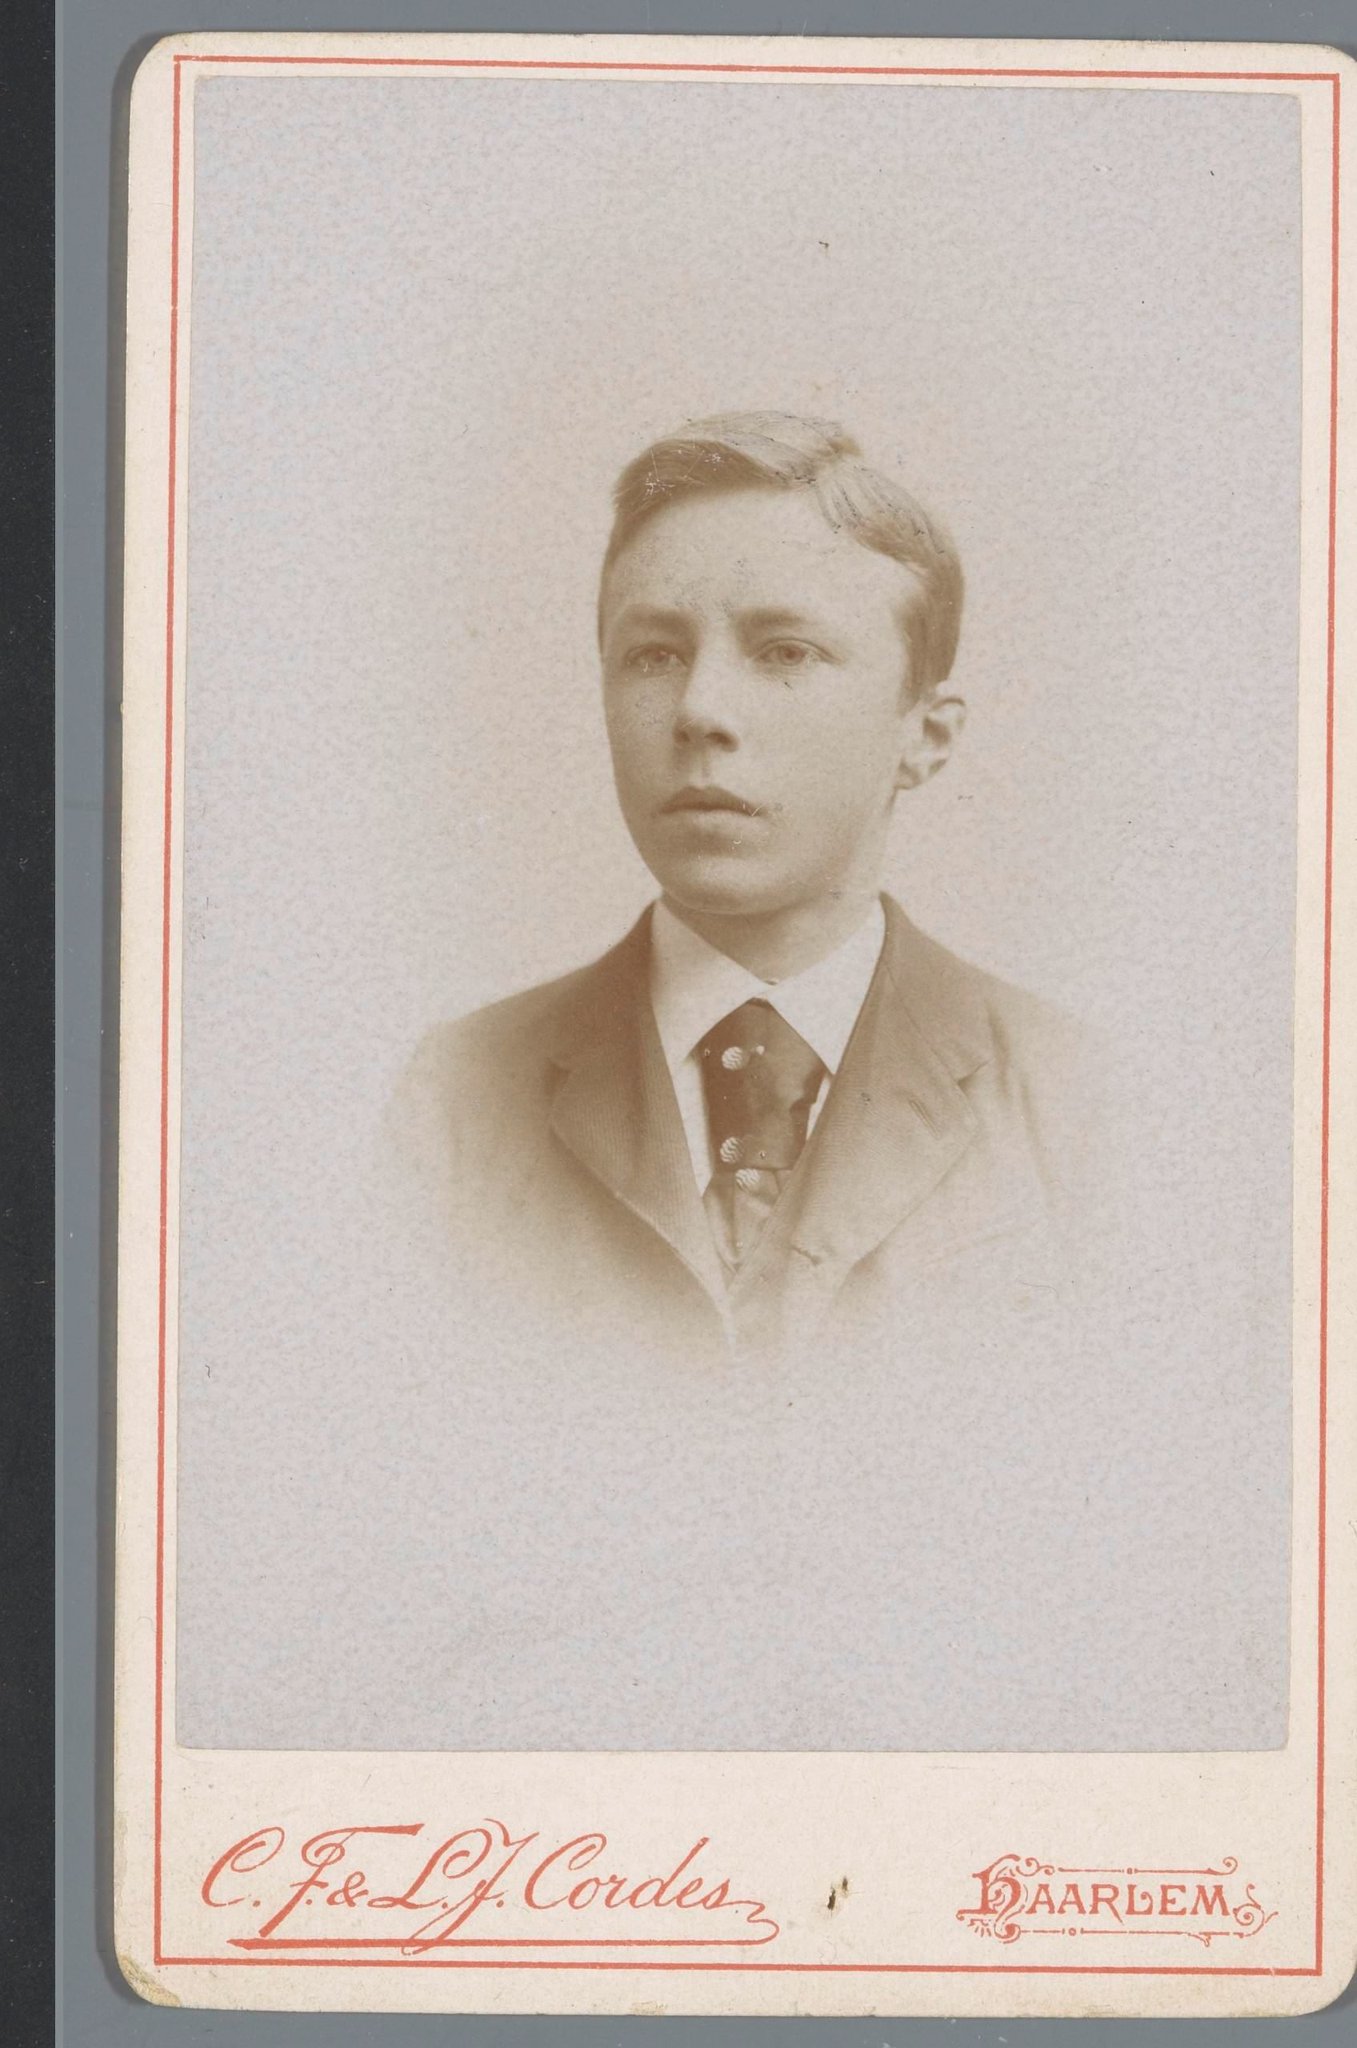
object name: carte de visite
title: Portret van een onbekende jongen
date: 1888-1901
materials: paper, cardboard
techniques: collodion silver print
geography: haarlem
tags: boy (child between toddler and youth), anonymous historical person portrayed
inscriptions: inscription: ‘Op verschillende tentoonstellingen bekroond voor Vergrootingen/ in kooldruk en andere photographien./ Met de hoogste onderscheiding op de Tentoonstelling van/ Kunstnijverheid te 's Hage./ De clichés blijven ter nabestelling bewaard./ Specialiteit in Kooldruk Vergrootingen.’, address: ‘Haarlem/ Groote Houtstraat 84,/ 's Bosch a/d. Parade.’